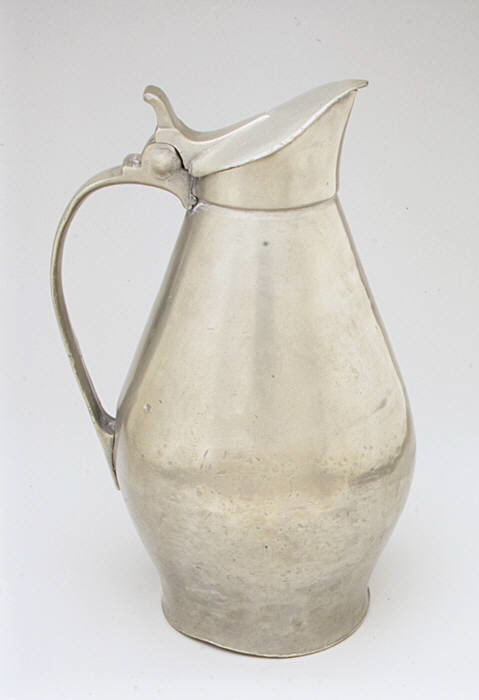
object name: cider measure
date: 1801-1900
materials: pewter